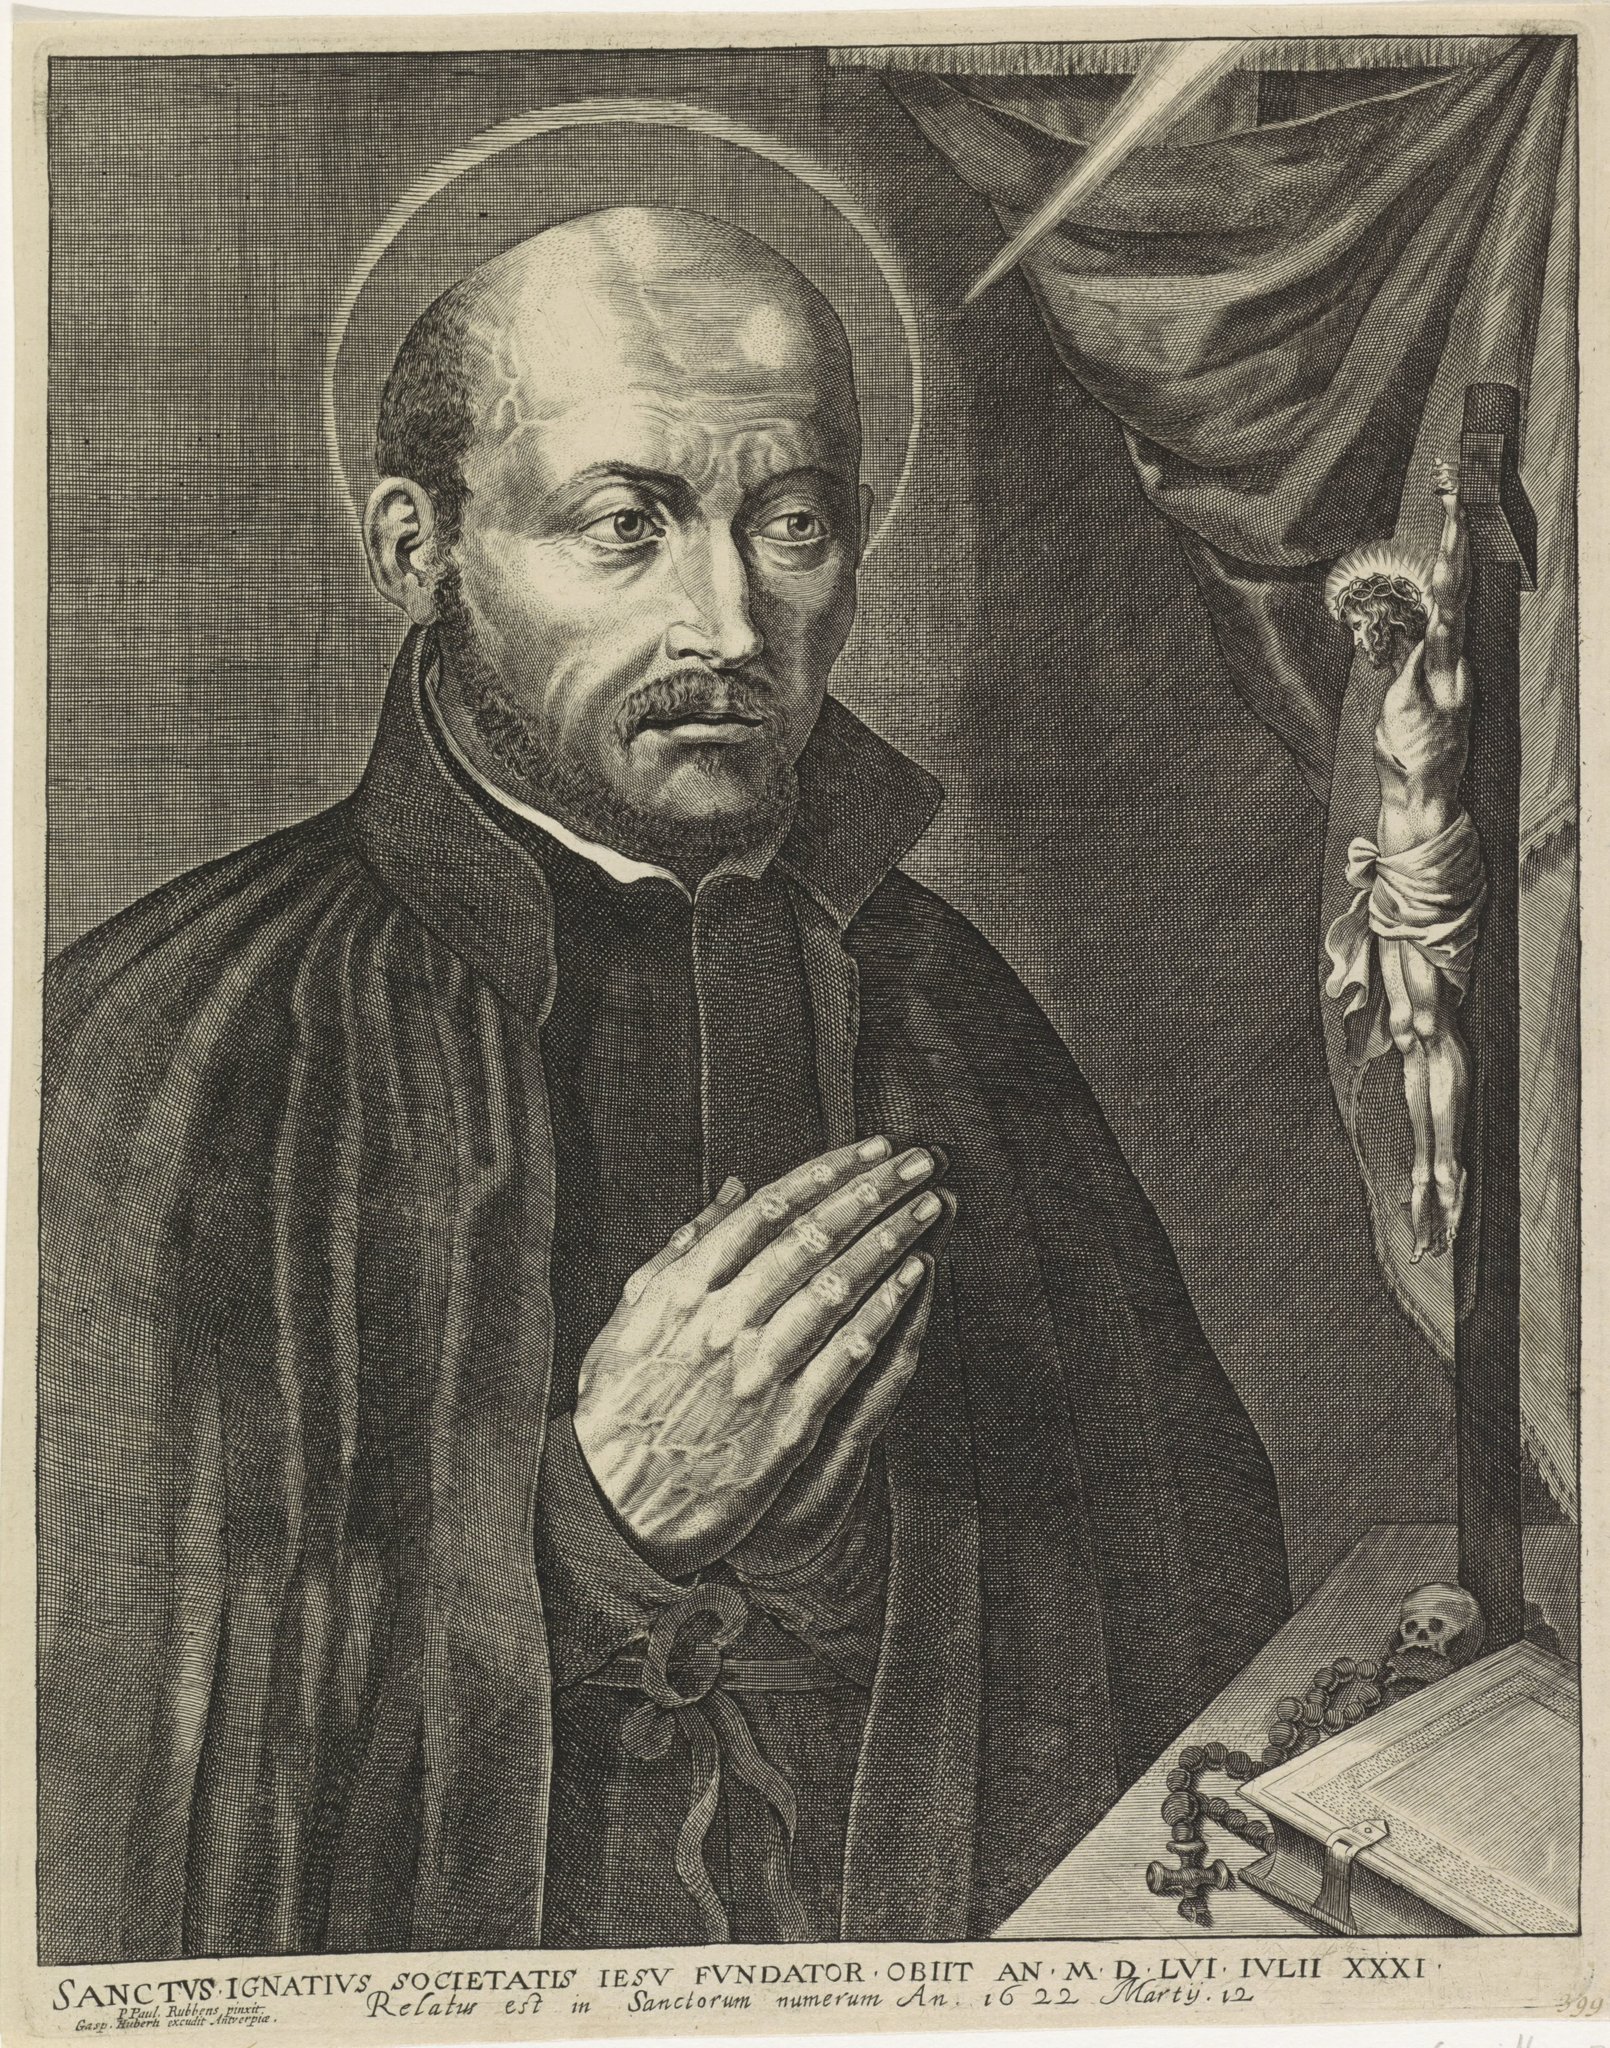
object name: print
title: H. Ignatius van Loyola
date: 1661-1684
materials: paper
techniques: engraving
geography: antwerp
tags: crucifix ~ personal devotion, personal devotion of st. ignatius of loyola - male saint meditating, in ecstasy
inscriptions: collector's mark: Lugt 240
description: De heilige Ignatius van Loyola in gebed bij een crucifix.